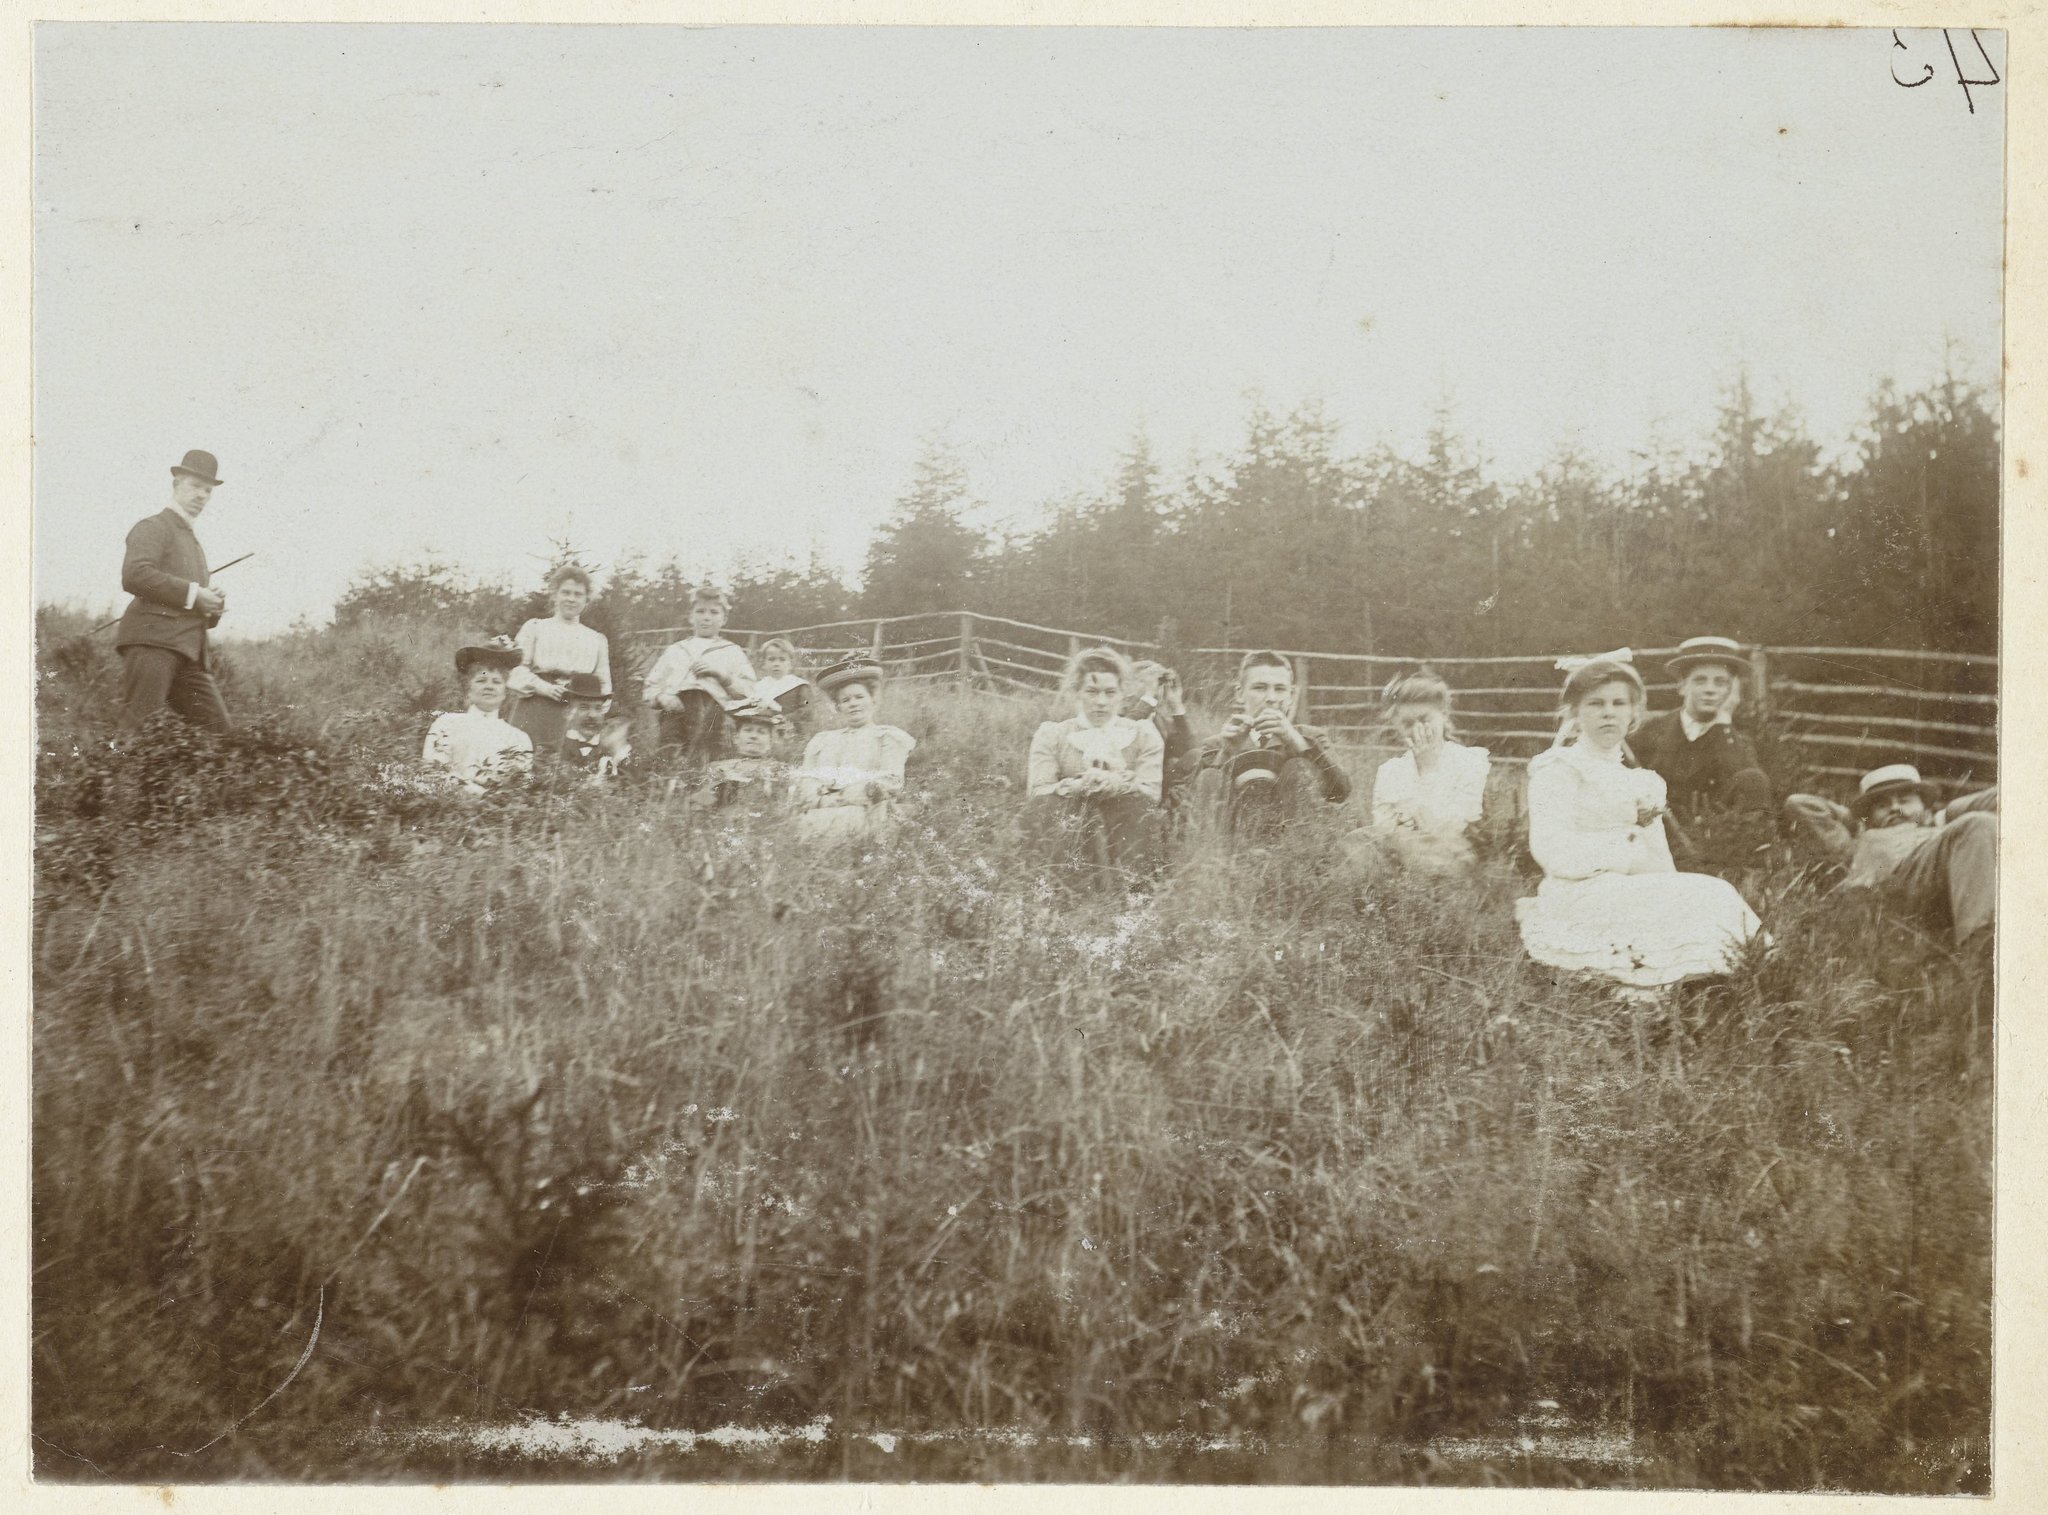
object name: photograph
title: De families Kessler en Heyning uitrustend in het hoge gras, vermoedelijk tijdens een wandeltocht in de Harz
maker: geldolph adriaan kessler (dolph)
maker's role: fotograaf, industrieel, voetballer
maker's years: 1884-1945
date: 1903-1908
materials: cardboard, photographic support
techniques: collodion silver print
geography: harz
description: De families Kessler en Heyning uitrustend in het hoge gras, vermoedelijk tijdens een wandeltocht in de Harz. Onderdeel van het fotoalbum van Dolph Kessler met opnamen die hij maakte tijdens zijn verblijf in Engeland en op een wereldreis die hij als secretaris van Henri Deterding (directeur Koninklijke Olie) ondernam naar Nederlands-Indië, Japan, China en de Verenigde Staten, tussen 1906 en 1908.